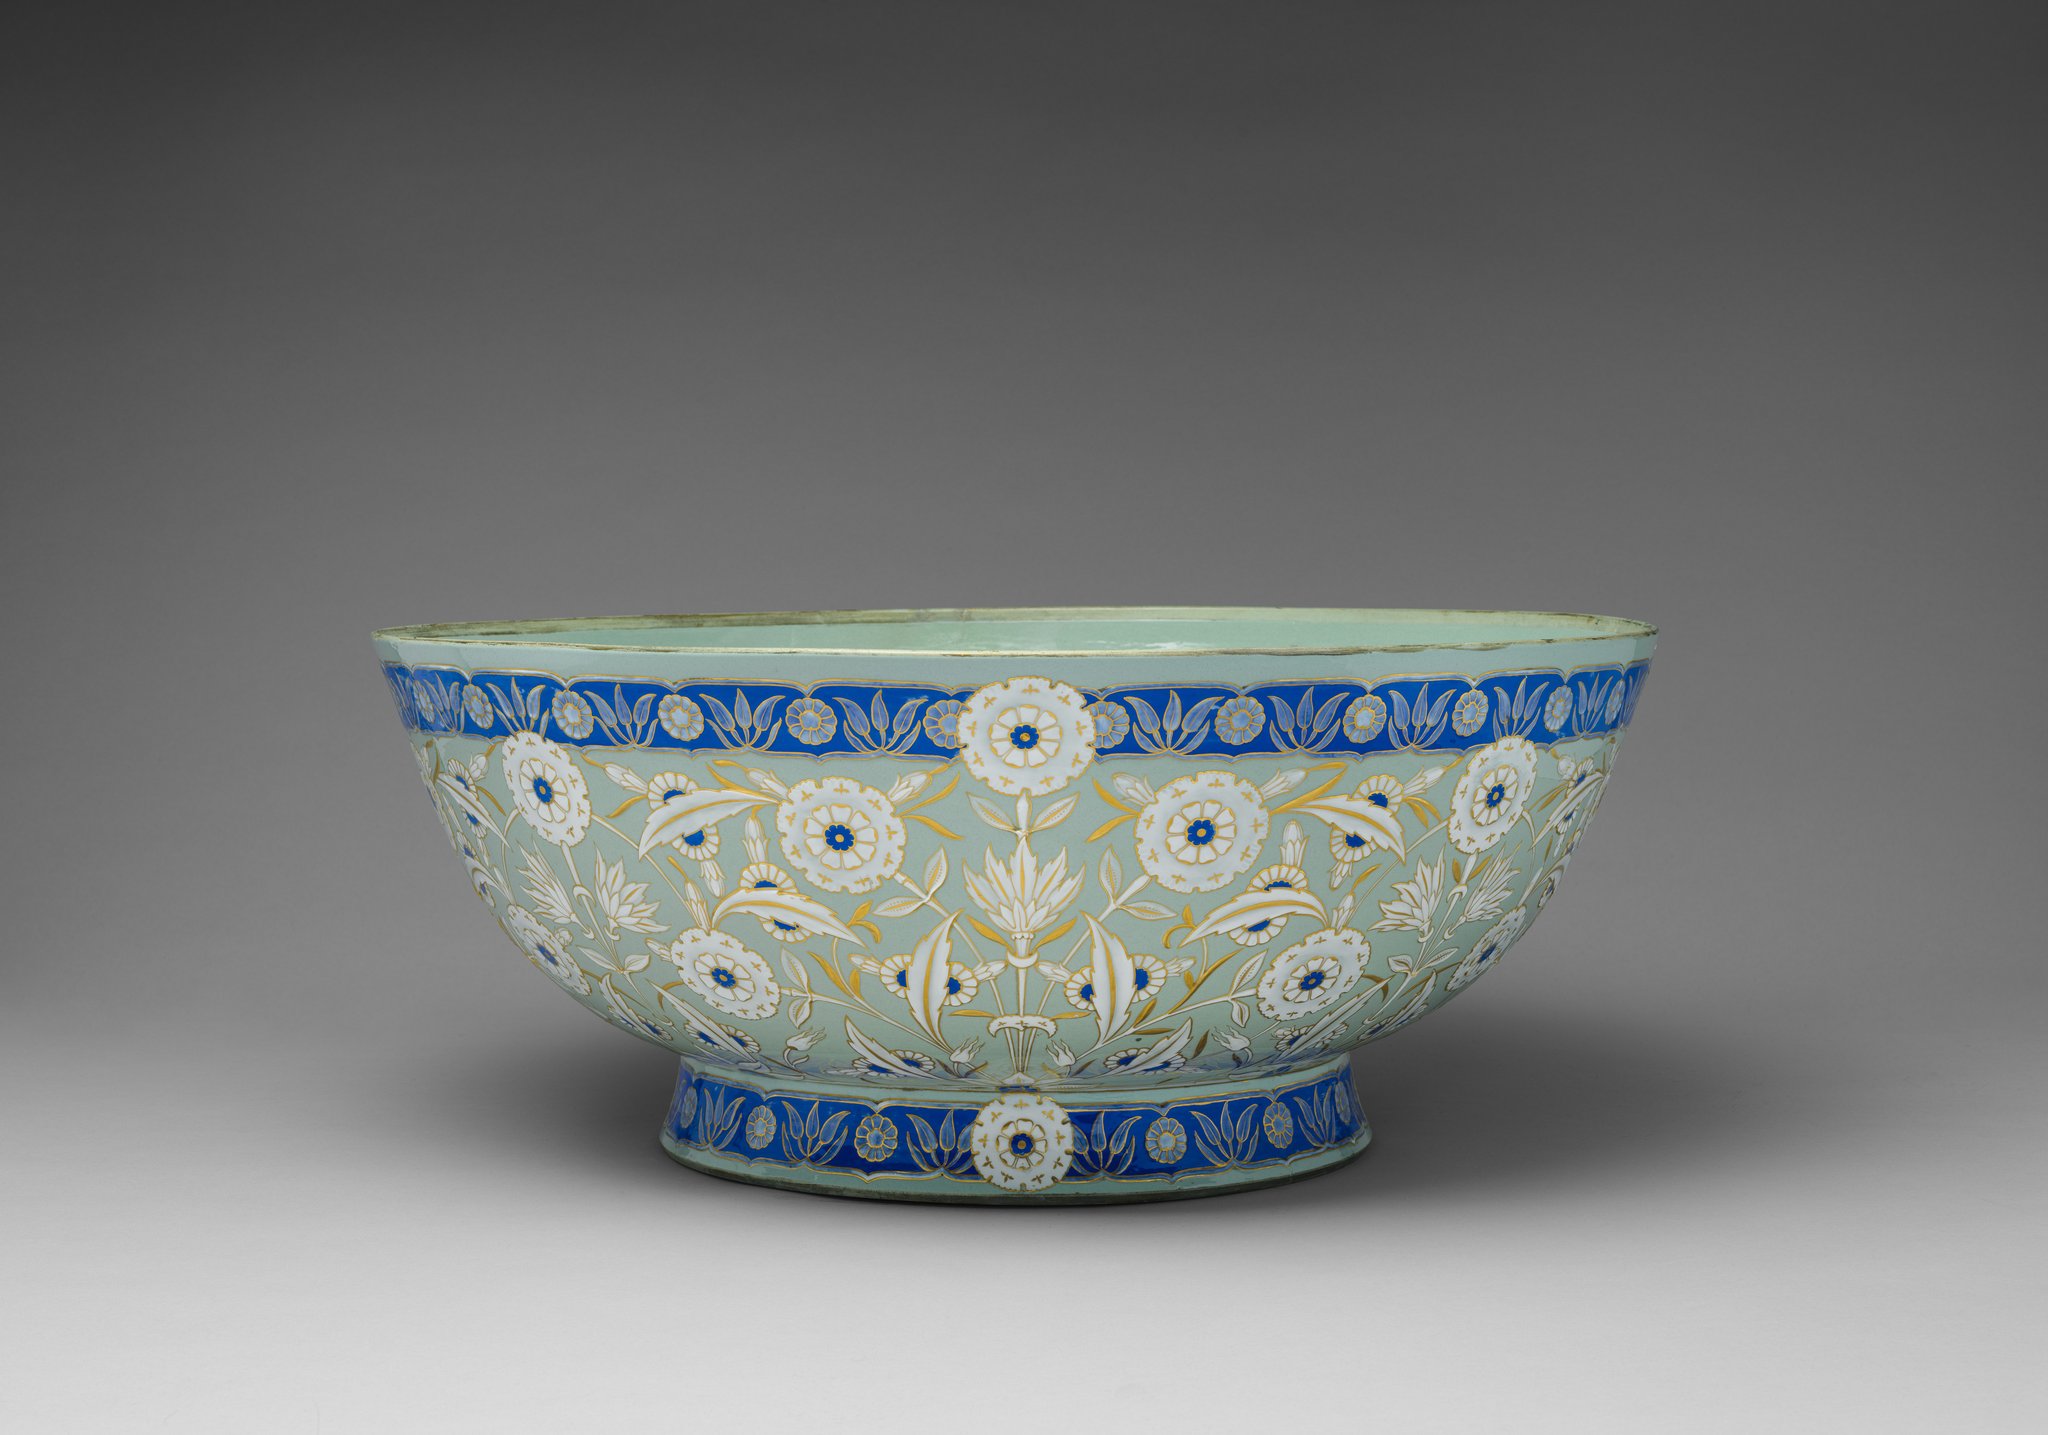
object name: bowl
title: Large Ceramic Bowl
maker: sèvres manufactory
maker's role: manufacturer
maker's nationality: french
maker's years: 1740-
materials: glaze, gold, hard paste porcelain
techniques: polychrome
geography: france